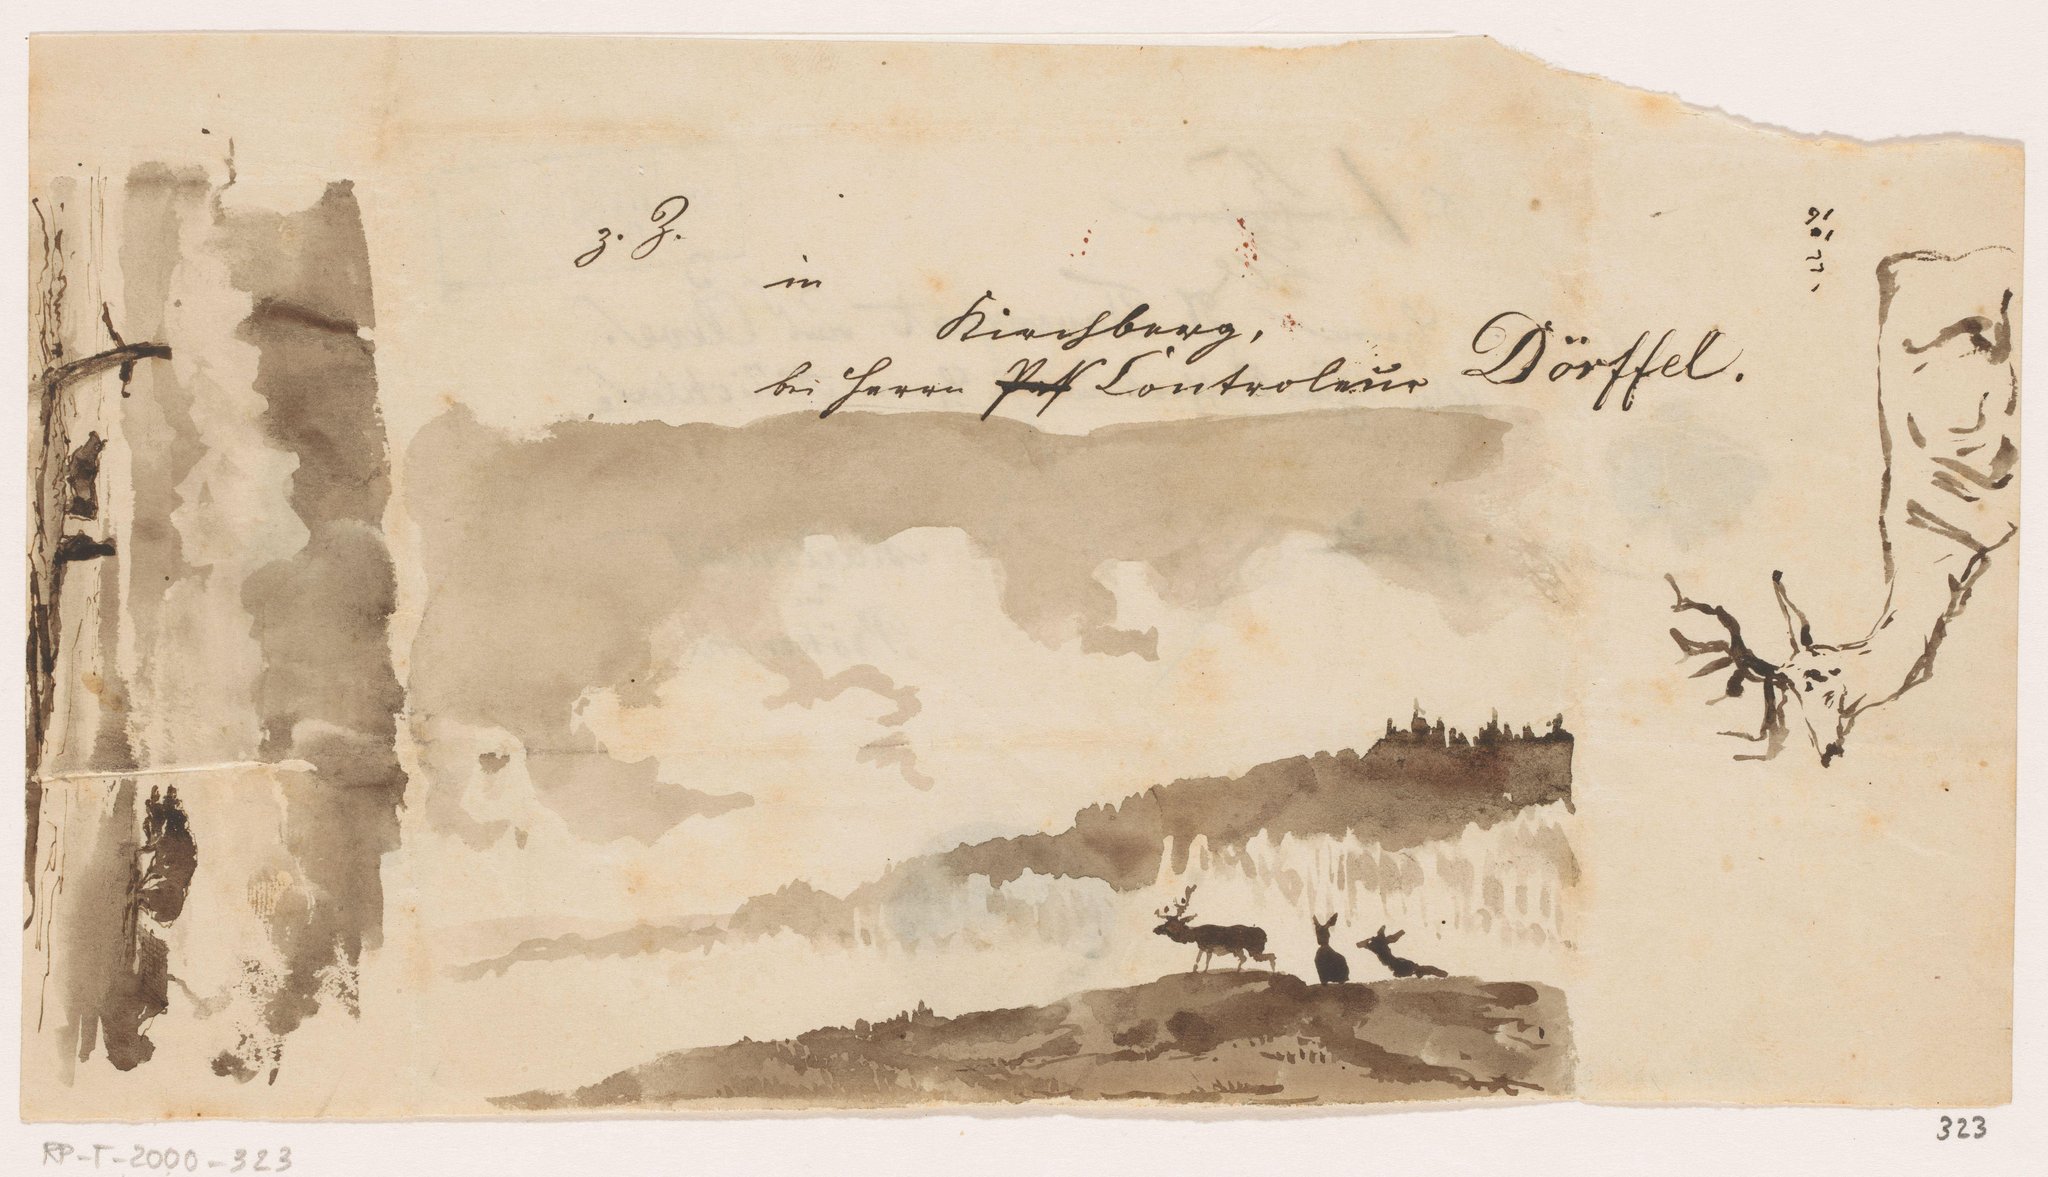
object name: drawing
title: Boslandschap en herten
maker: johannes tavenraat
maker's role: draughtsman, painter, print maker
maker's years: 1809-1881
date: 1840-1880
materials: ink, lacquer, paper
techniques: brush, pen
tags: hoofed animals: deer, forest, wood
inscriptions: annotation:, collector's mark: Lugt 2228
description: Schetsen van boslandschappen en herten. Getekend op de binnenzijde van een envelop met lakzegel, gericht aan Tavenraat in Kleef en doorgestuurd naar Mariënbad in Bohemen.